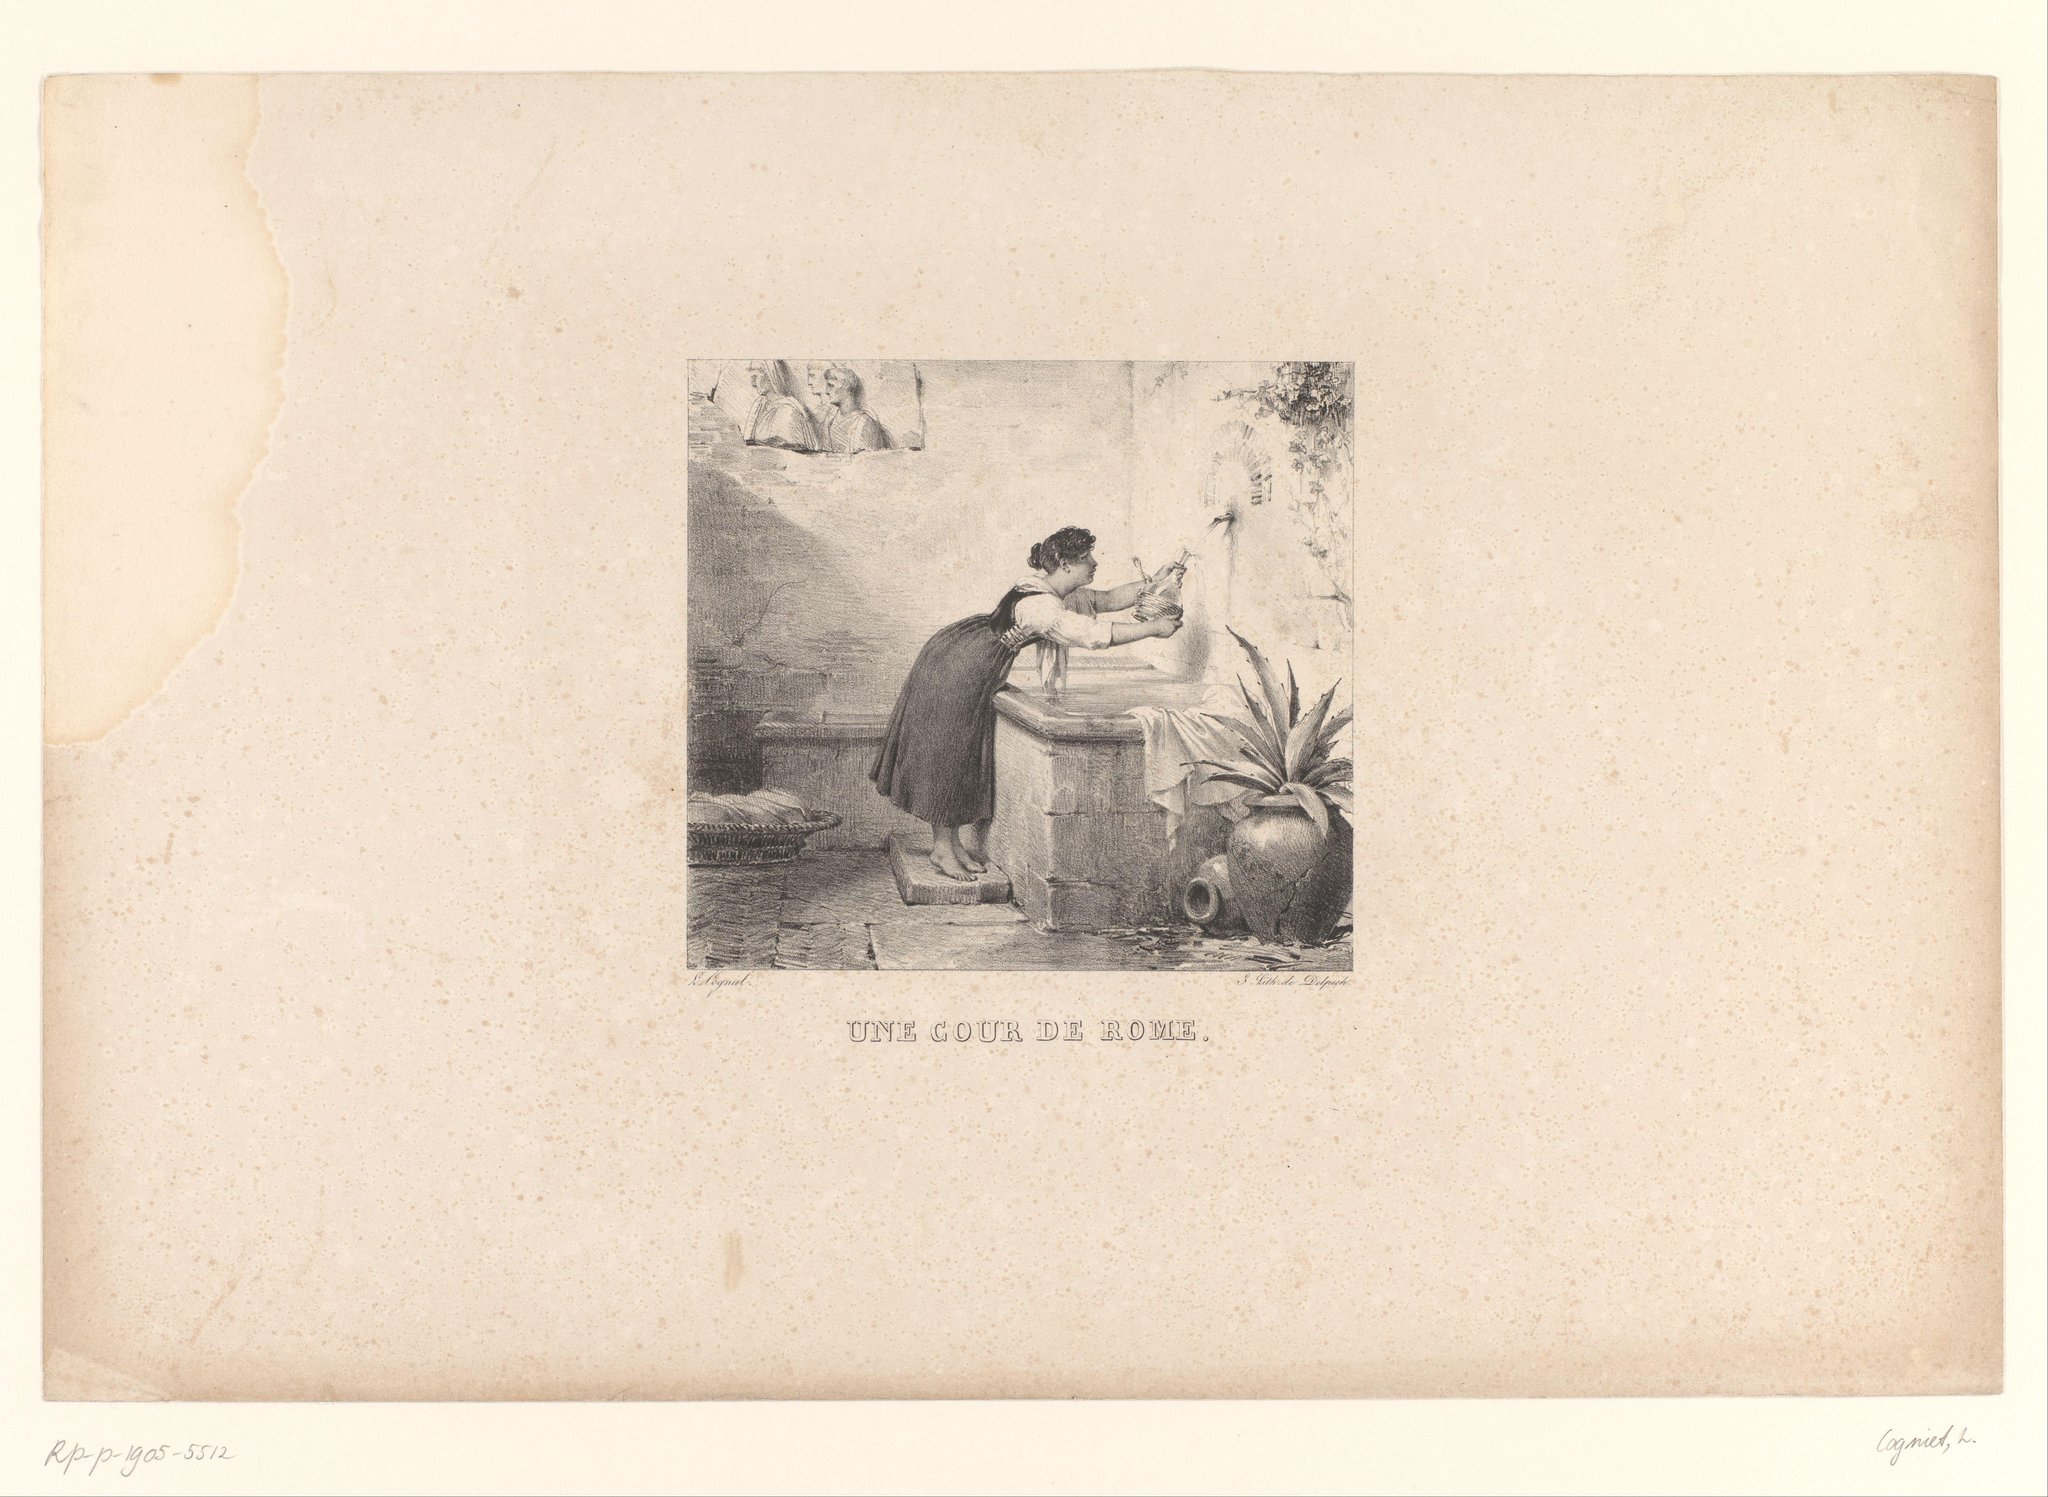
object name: print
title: Romeins meisje vult een waterkruik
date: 1824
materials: paper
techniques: lithograph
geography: paris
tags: adolescent, young woman, maiden, courtyard, utilitarian, public pump or water fountain, rome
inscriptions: collector's mark: Lugt 2228a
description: Een meisje vult een waterkruik bij een fontein op een binnenplaats in Rome.